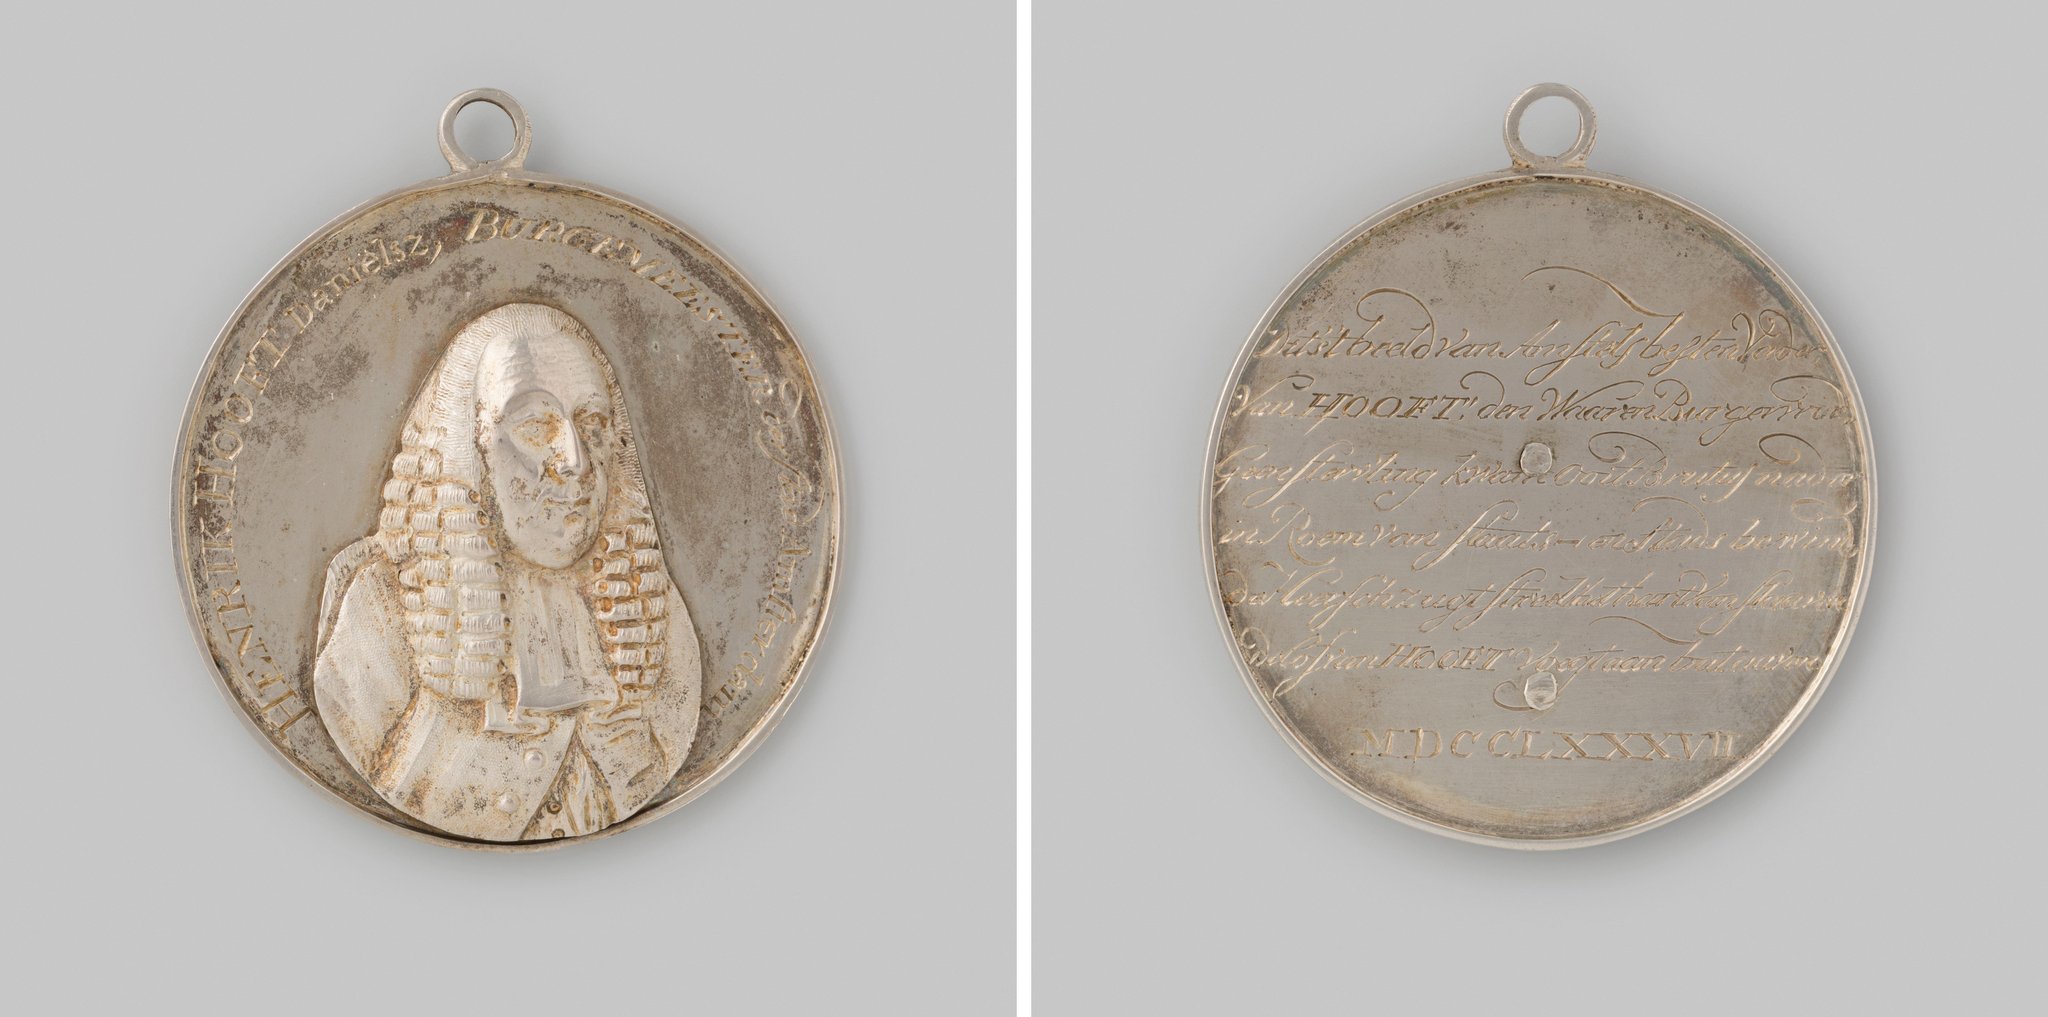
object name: insignia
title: Hendrik Danielsz. Hooft, burgemeester van Amsterdam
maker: Anonymous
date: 1787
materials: silver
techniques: engraving, fastening, striking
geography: netherlands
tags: amsterdam, mayor, hendrik danielsz. hooft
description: Zilveren draagteken aan draagoog. Voorzijde: borststuk man binnen omschrift. Keerzijde: opschrift; op keerzijde zijn nog twee nagels zichtbaar, waarmee voor- en keerzijde aan elkaar zijn bevestigd